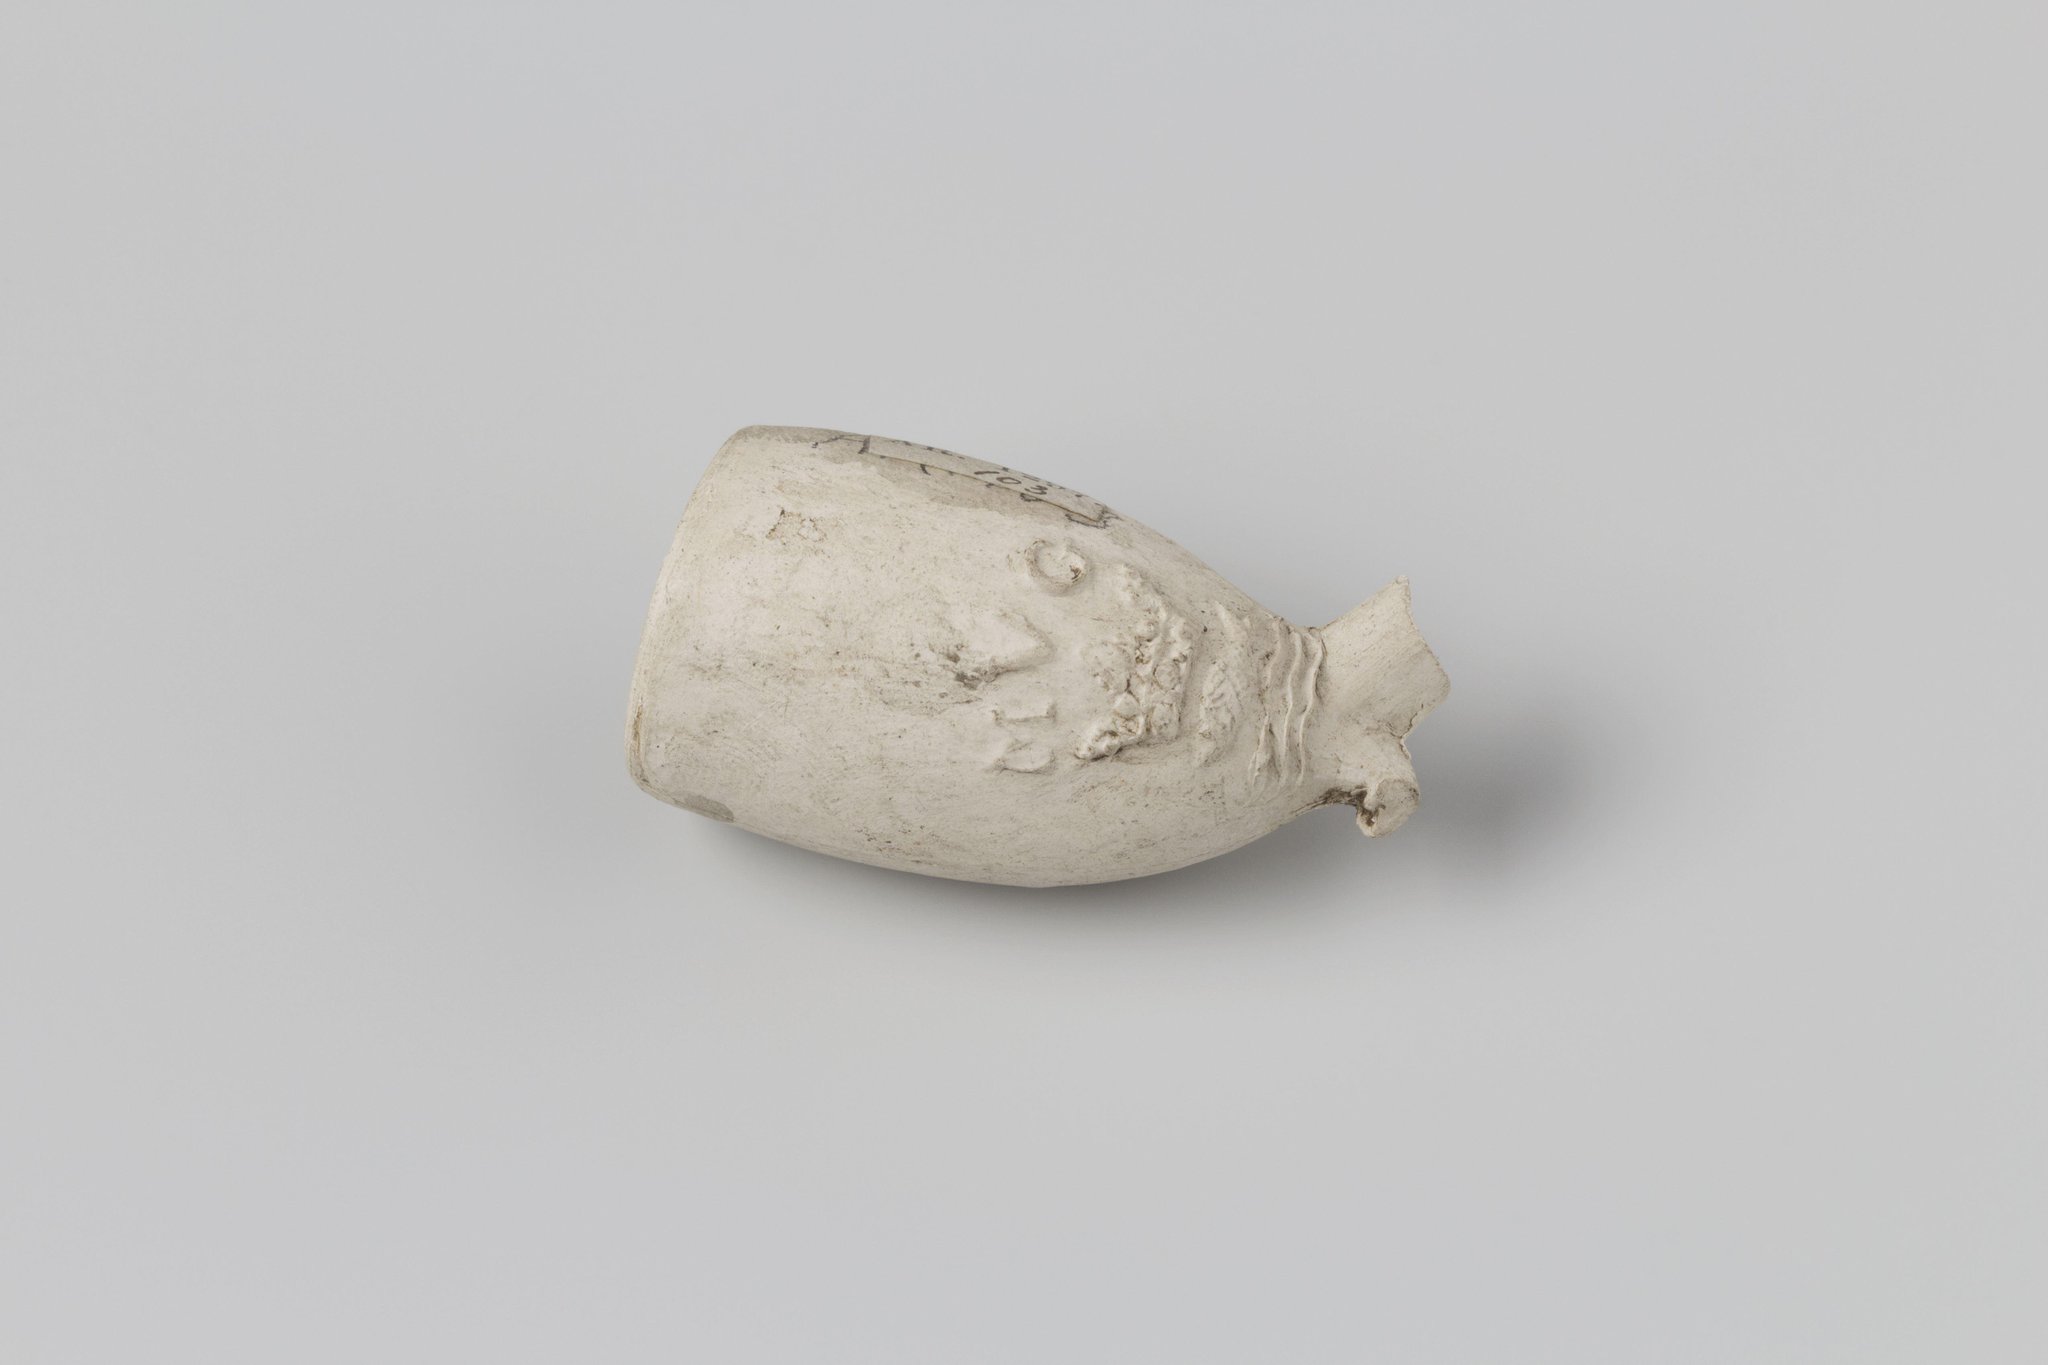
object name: pipe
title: Fragment pijpenkop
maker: machiel van genderen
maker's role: pijpenfabrikant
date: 1750-1785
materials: clay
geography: schoonhoven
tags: directeur, hoogleraar, caspar jacob christiaan reuvens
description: Fragment pijpenkop met een kroon, een vis en drie golven en de letters M V G afgebeeld. Van de opgravingen op de Hofstede Arentsburg 1827-1831 onder toezicht van Professor Reuvens.